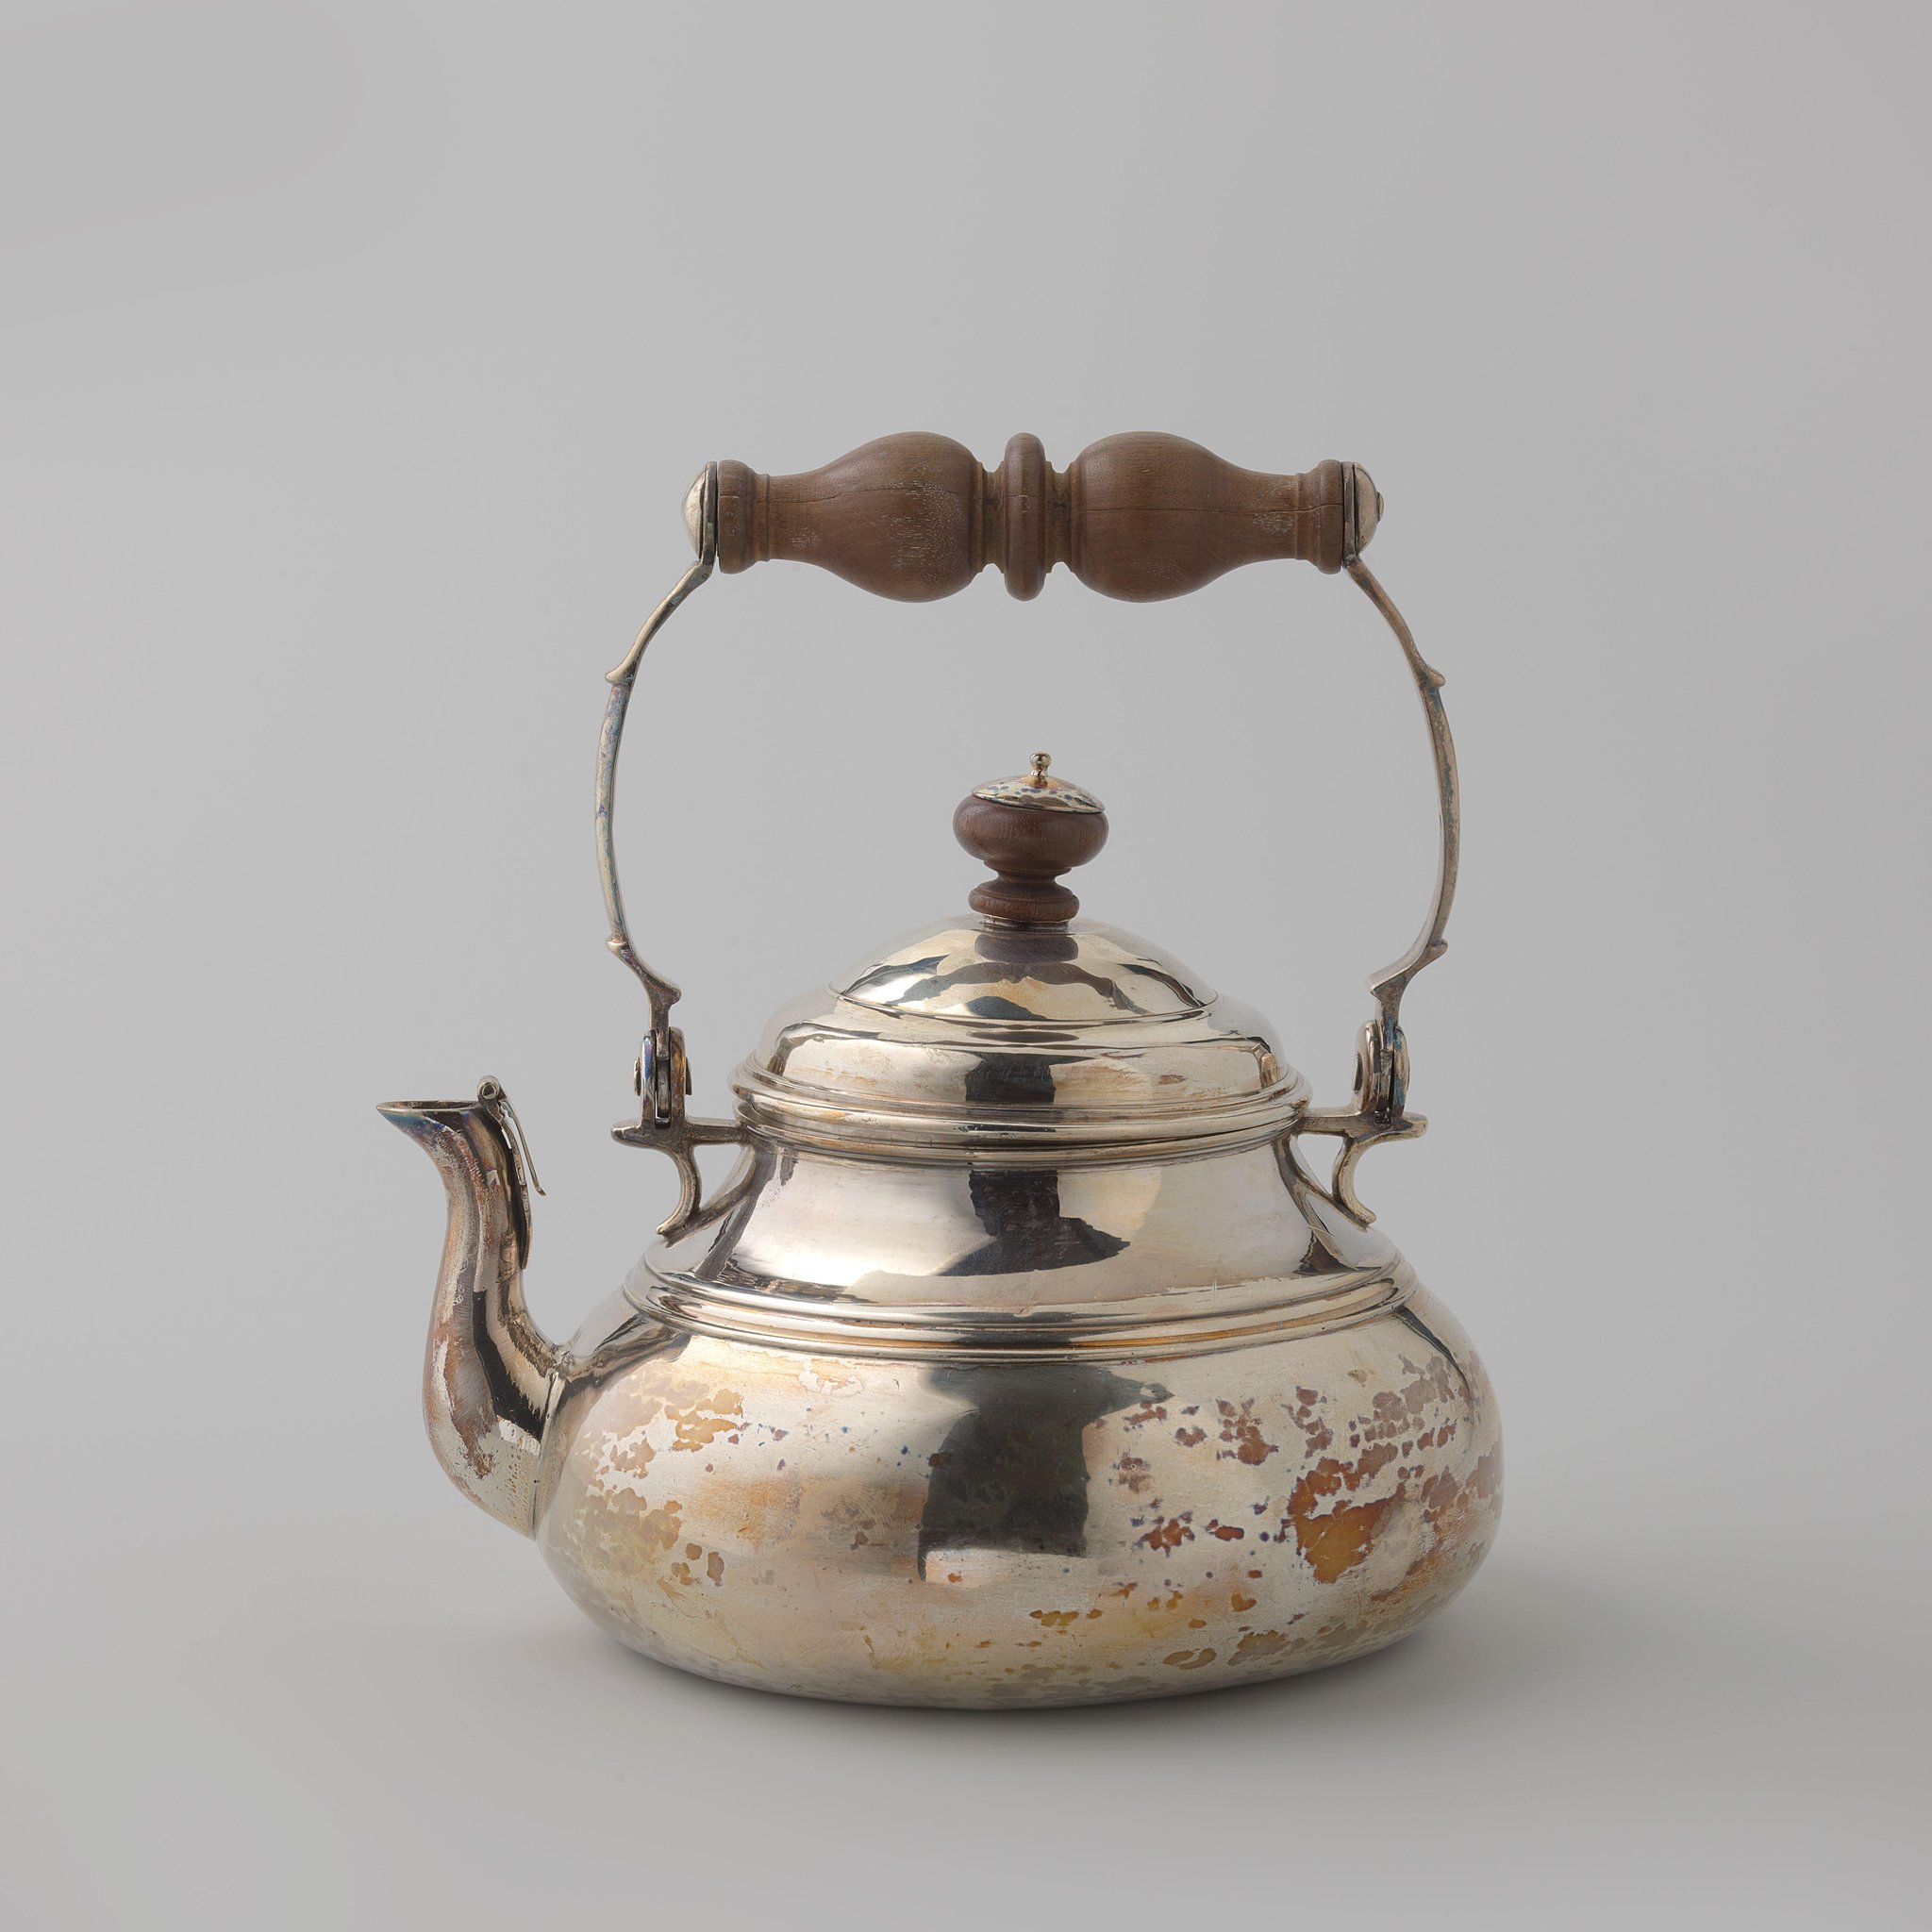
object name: teakettle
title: Ketel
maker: john wisdom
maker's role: silversmith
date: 1705-1706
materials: silver, wood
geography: london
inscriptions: mark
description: Ketel van zilver. Het ronde vat is sterk verbreed aan de onderzijde en heeft op tweederde van de hoogte een profiel. Het hengsel heeft een gedraaid houten handvat. De tuit wordt afgesoten met een klepje.